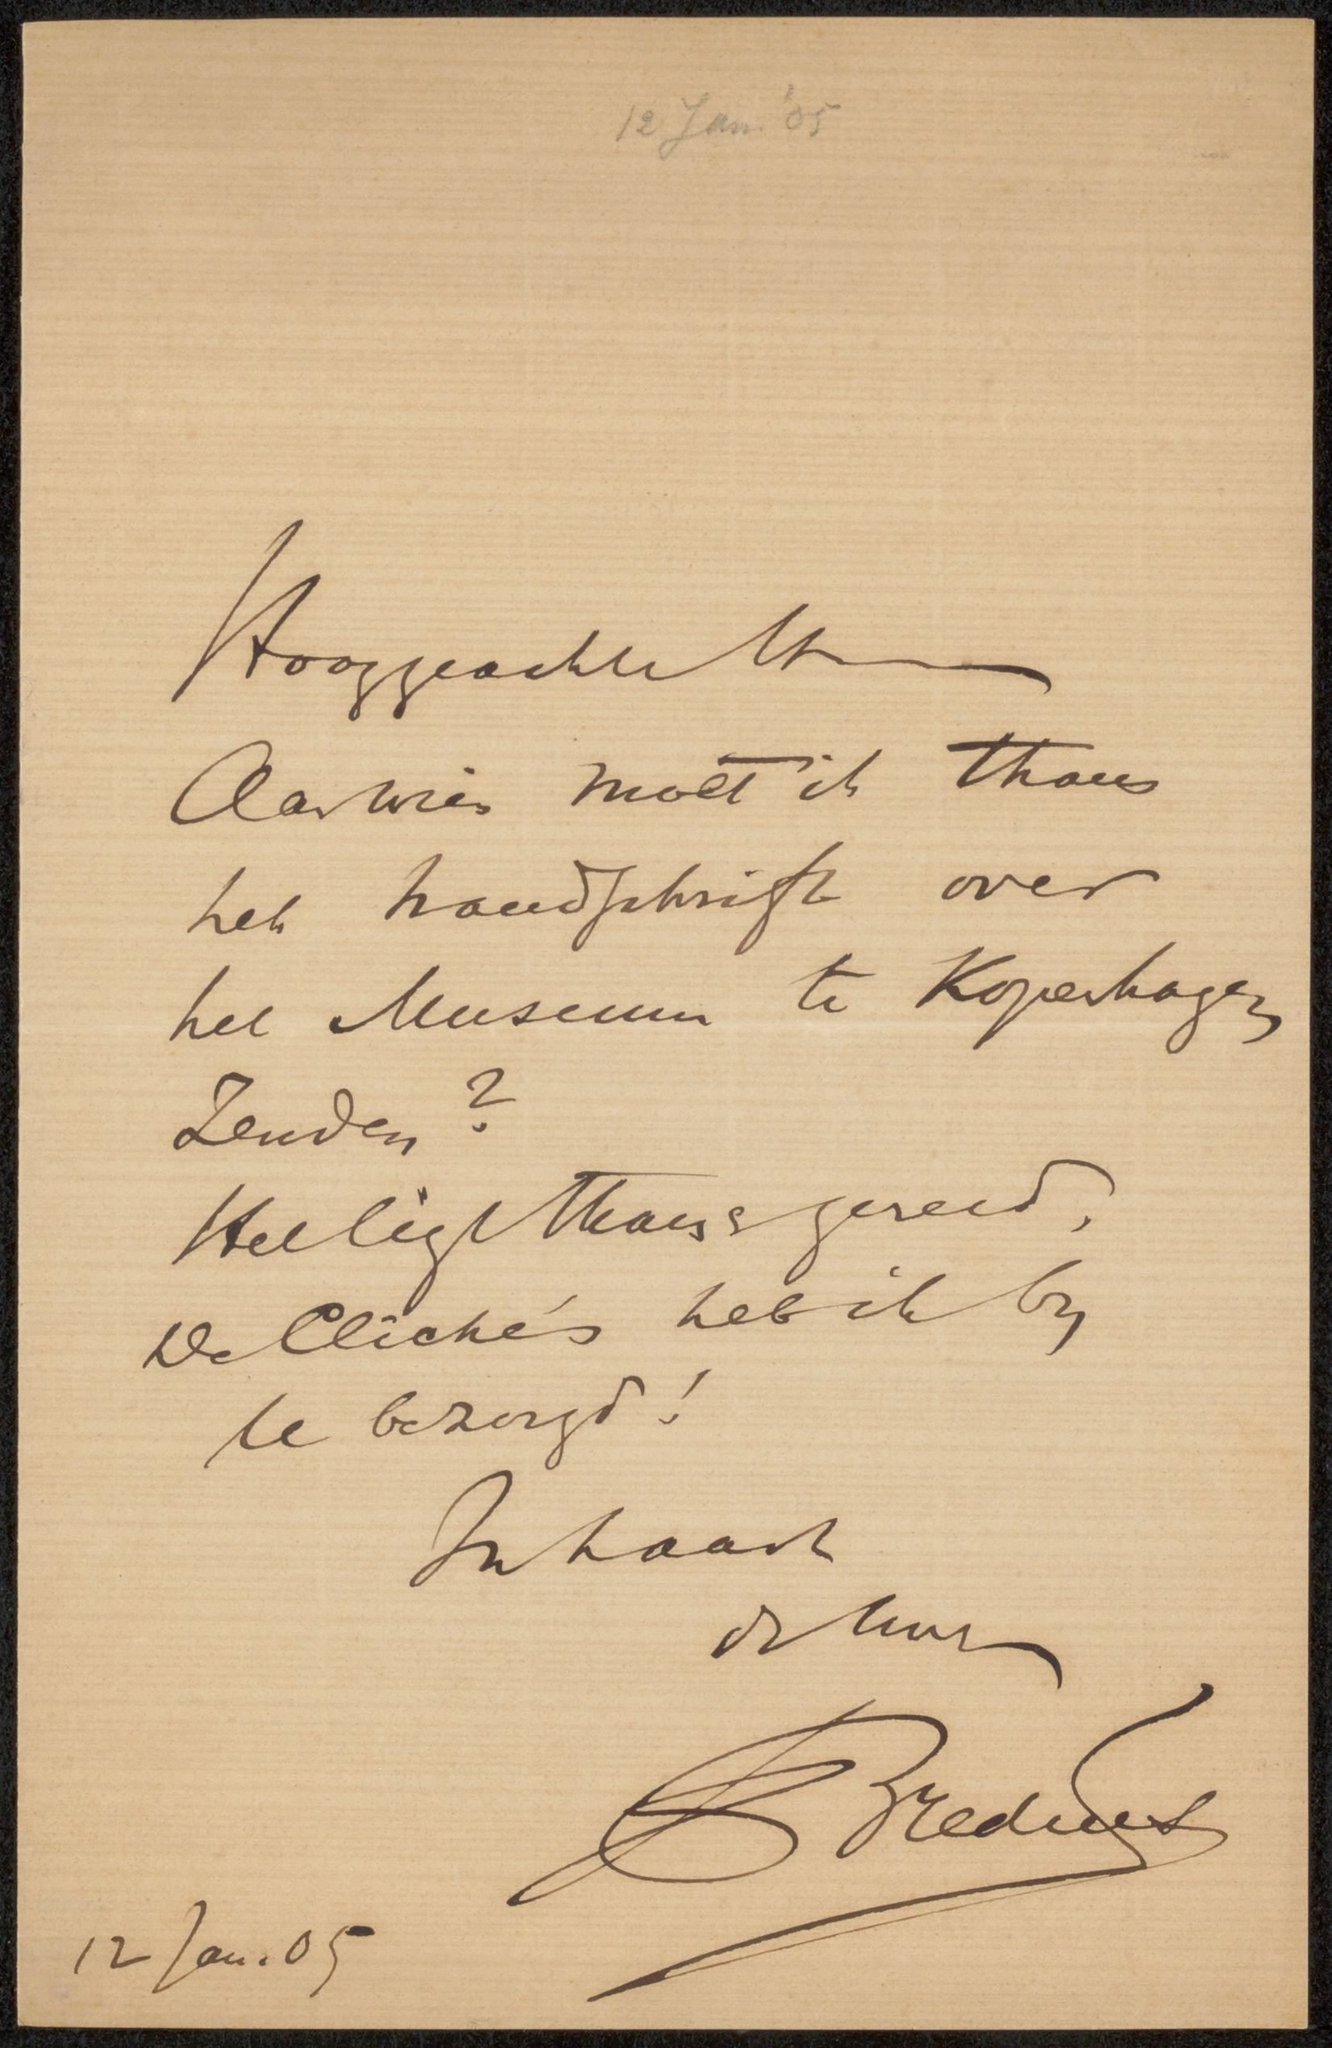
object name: letter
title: Brief aan Philip Zilcken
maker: abraham bredius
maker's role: kunsthistoricus, museumdirecteur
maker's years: 1855-1946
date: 1905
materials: ink, paper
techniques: pen, writing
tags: the hague, painter, draughtsman, philip zilcken, copenhagen (city)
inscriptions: collector's mark: ‘RPK’